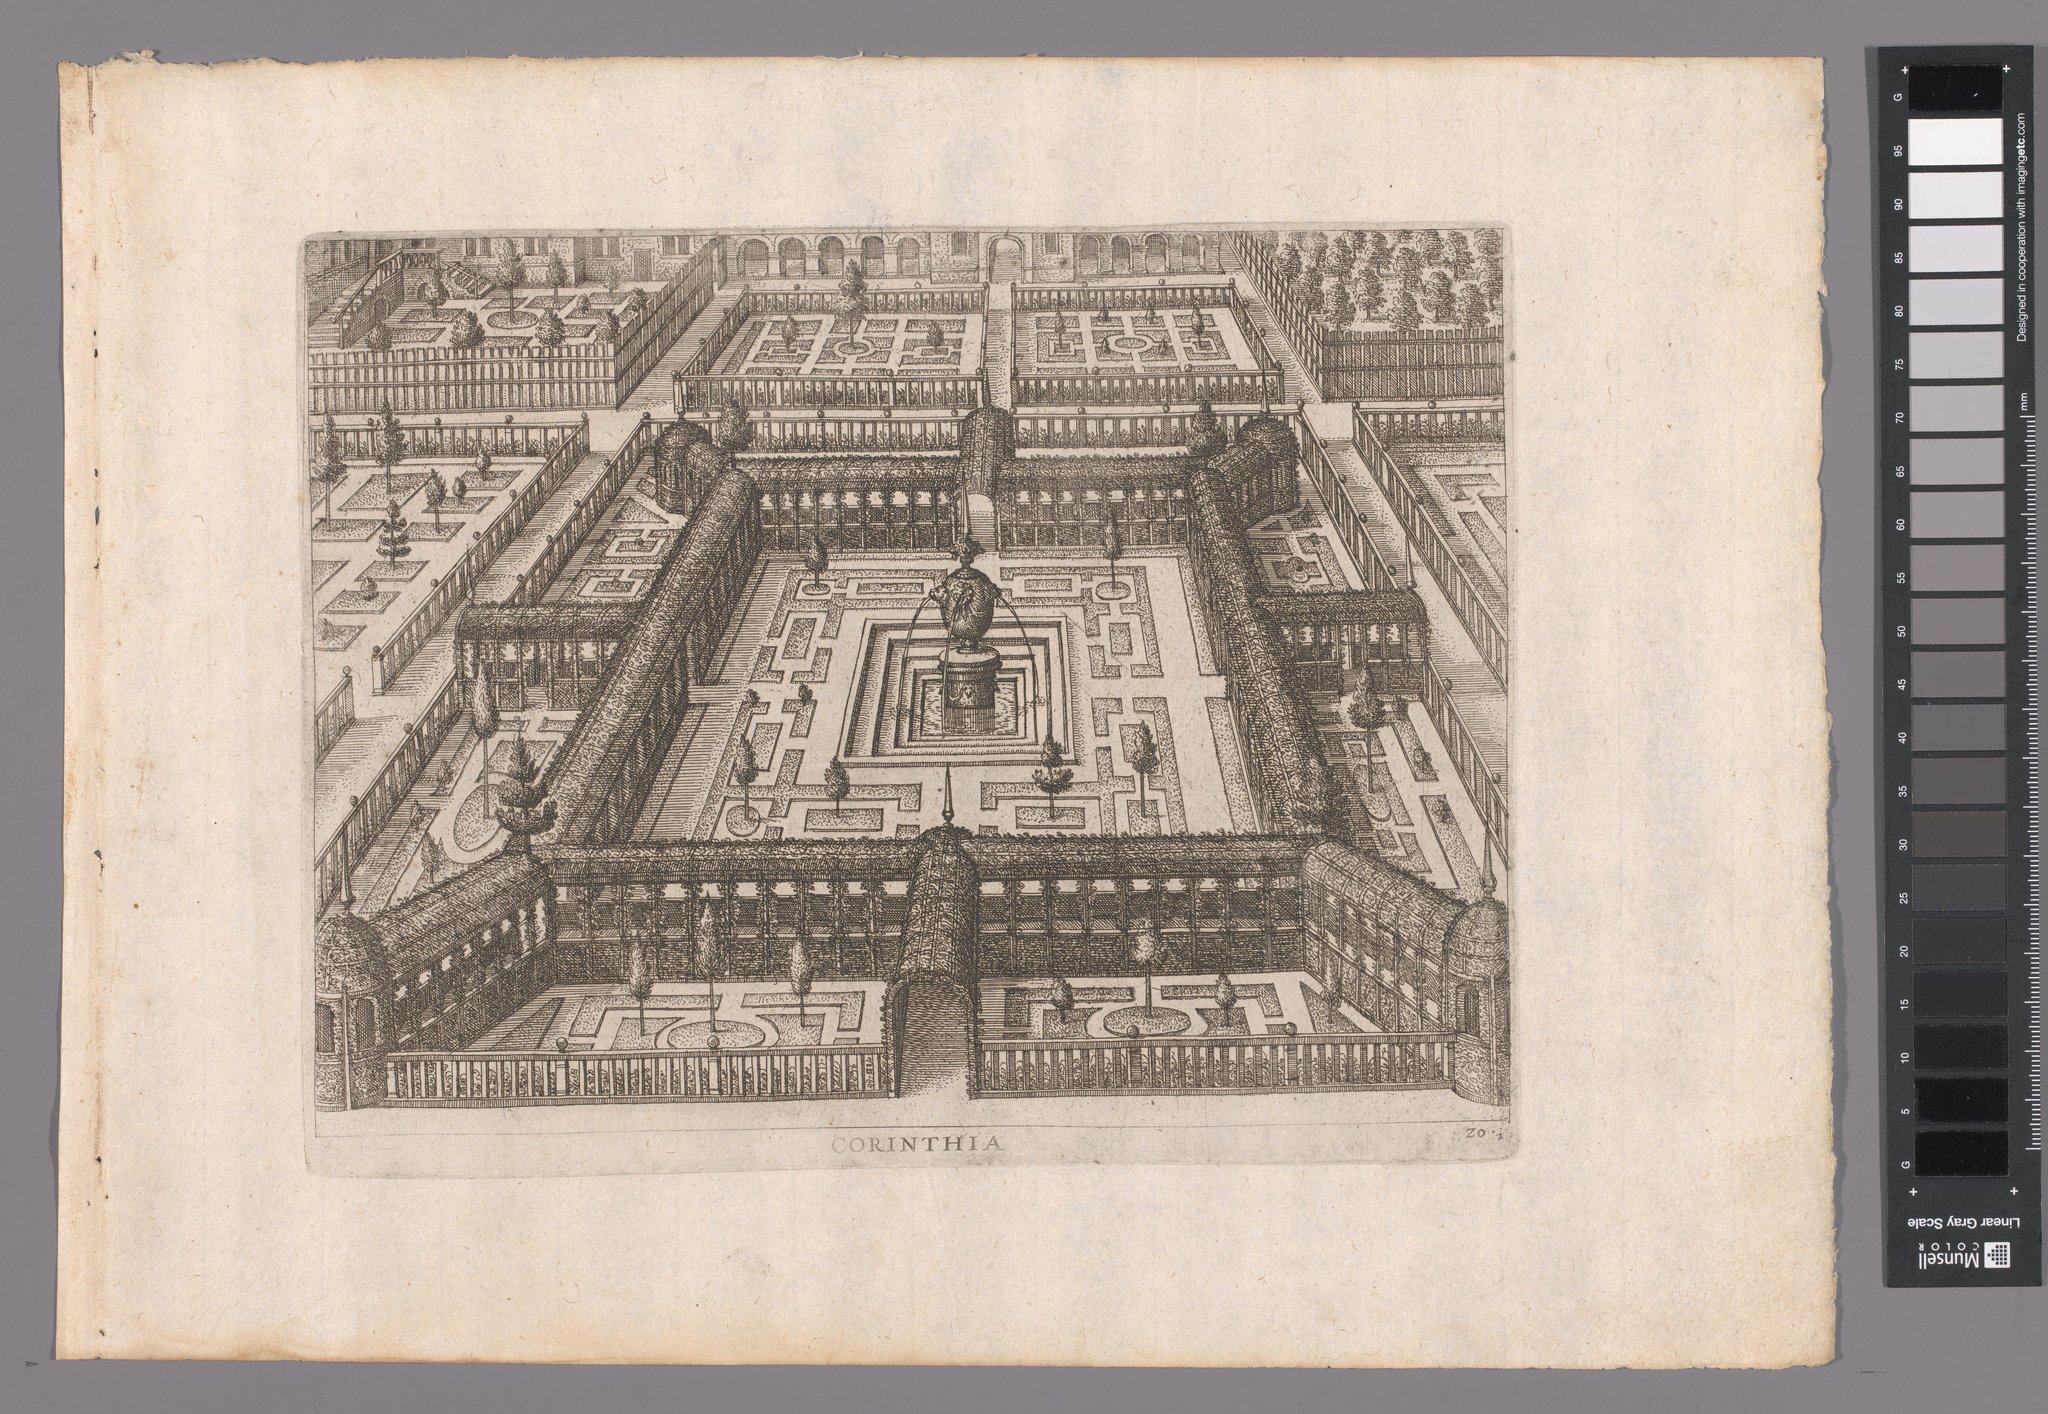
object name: ornament print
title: Hortorum Viridariorumque elegantes et multiplicis formae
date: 1583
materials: paper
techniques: etching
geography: antwerp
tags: garden, french or architectonic garden; formal garden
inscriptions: collector's mark: Lugt 2228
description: Tuin met een parterre omgeven door een begroeide gang van traliewerk. In het centrum een fontein met een vaas. De tuin is aangelegd volgens de Korinthische bouworde.